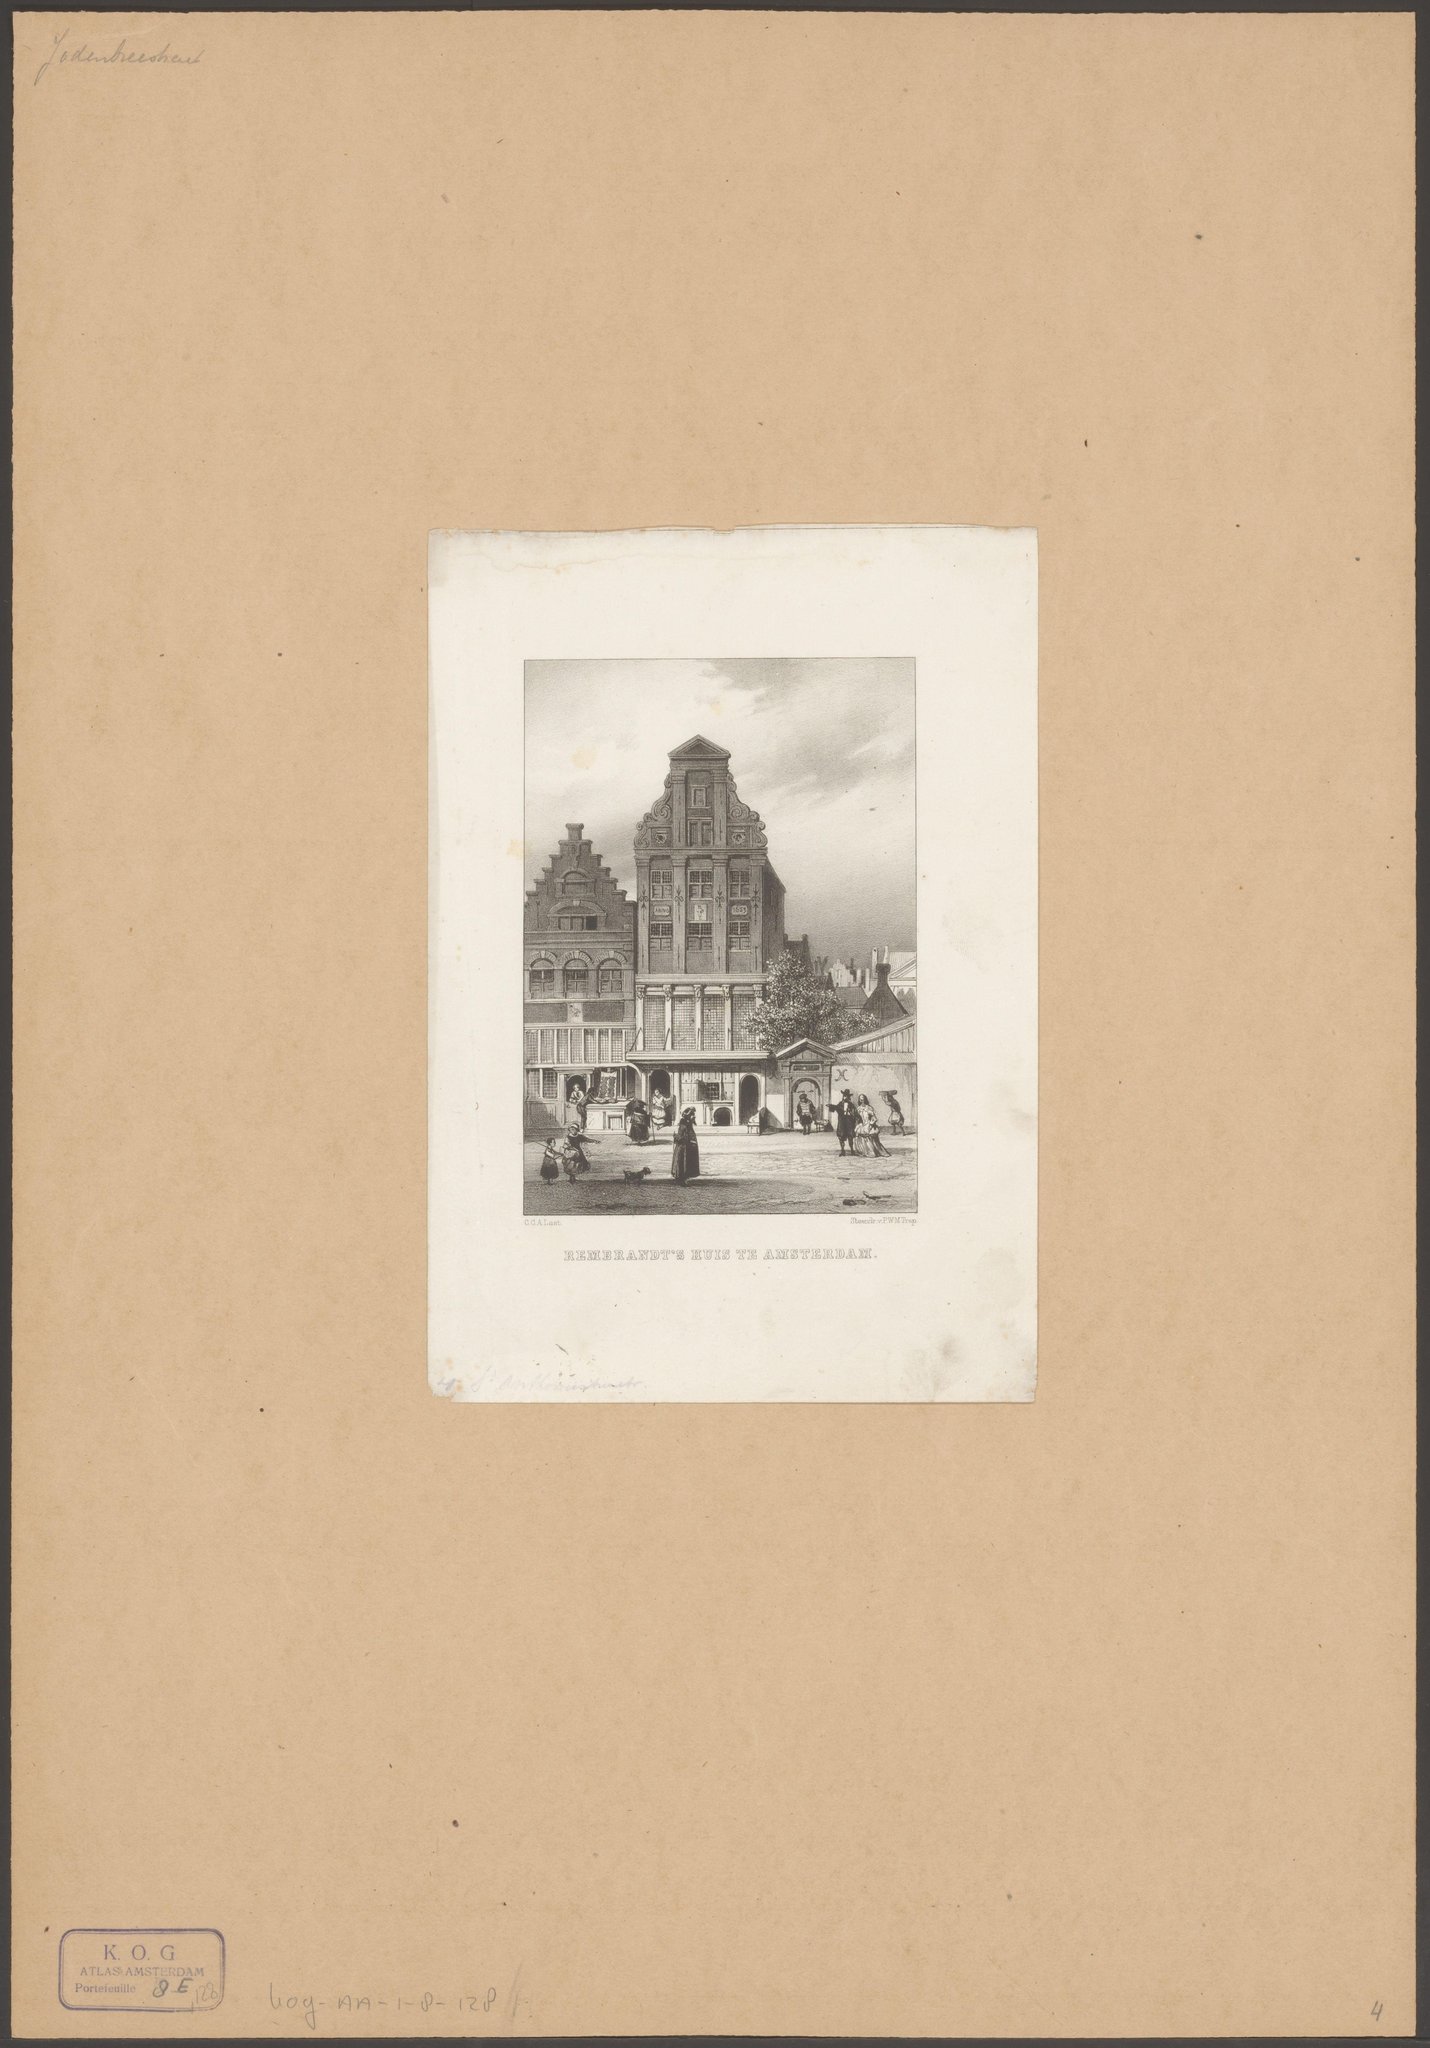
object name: print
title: Gezicht op het huis van Rembrandt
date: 1836-1876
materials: paper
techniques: lithograph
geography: leiden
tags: city-view in general; 'veduta', façade (of house or building)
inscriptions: collector's mark: ‘8E128’ Lugt 1641b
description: Onderwerpsrubriek binnen de Atlas Amsterdam: Jacobszstraat (Pieter), Jodenbreestraat, Jodenhoek, Jonge Roelensteeg, Jonker- en Ridderstraat.